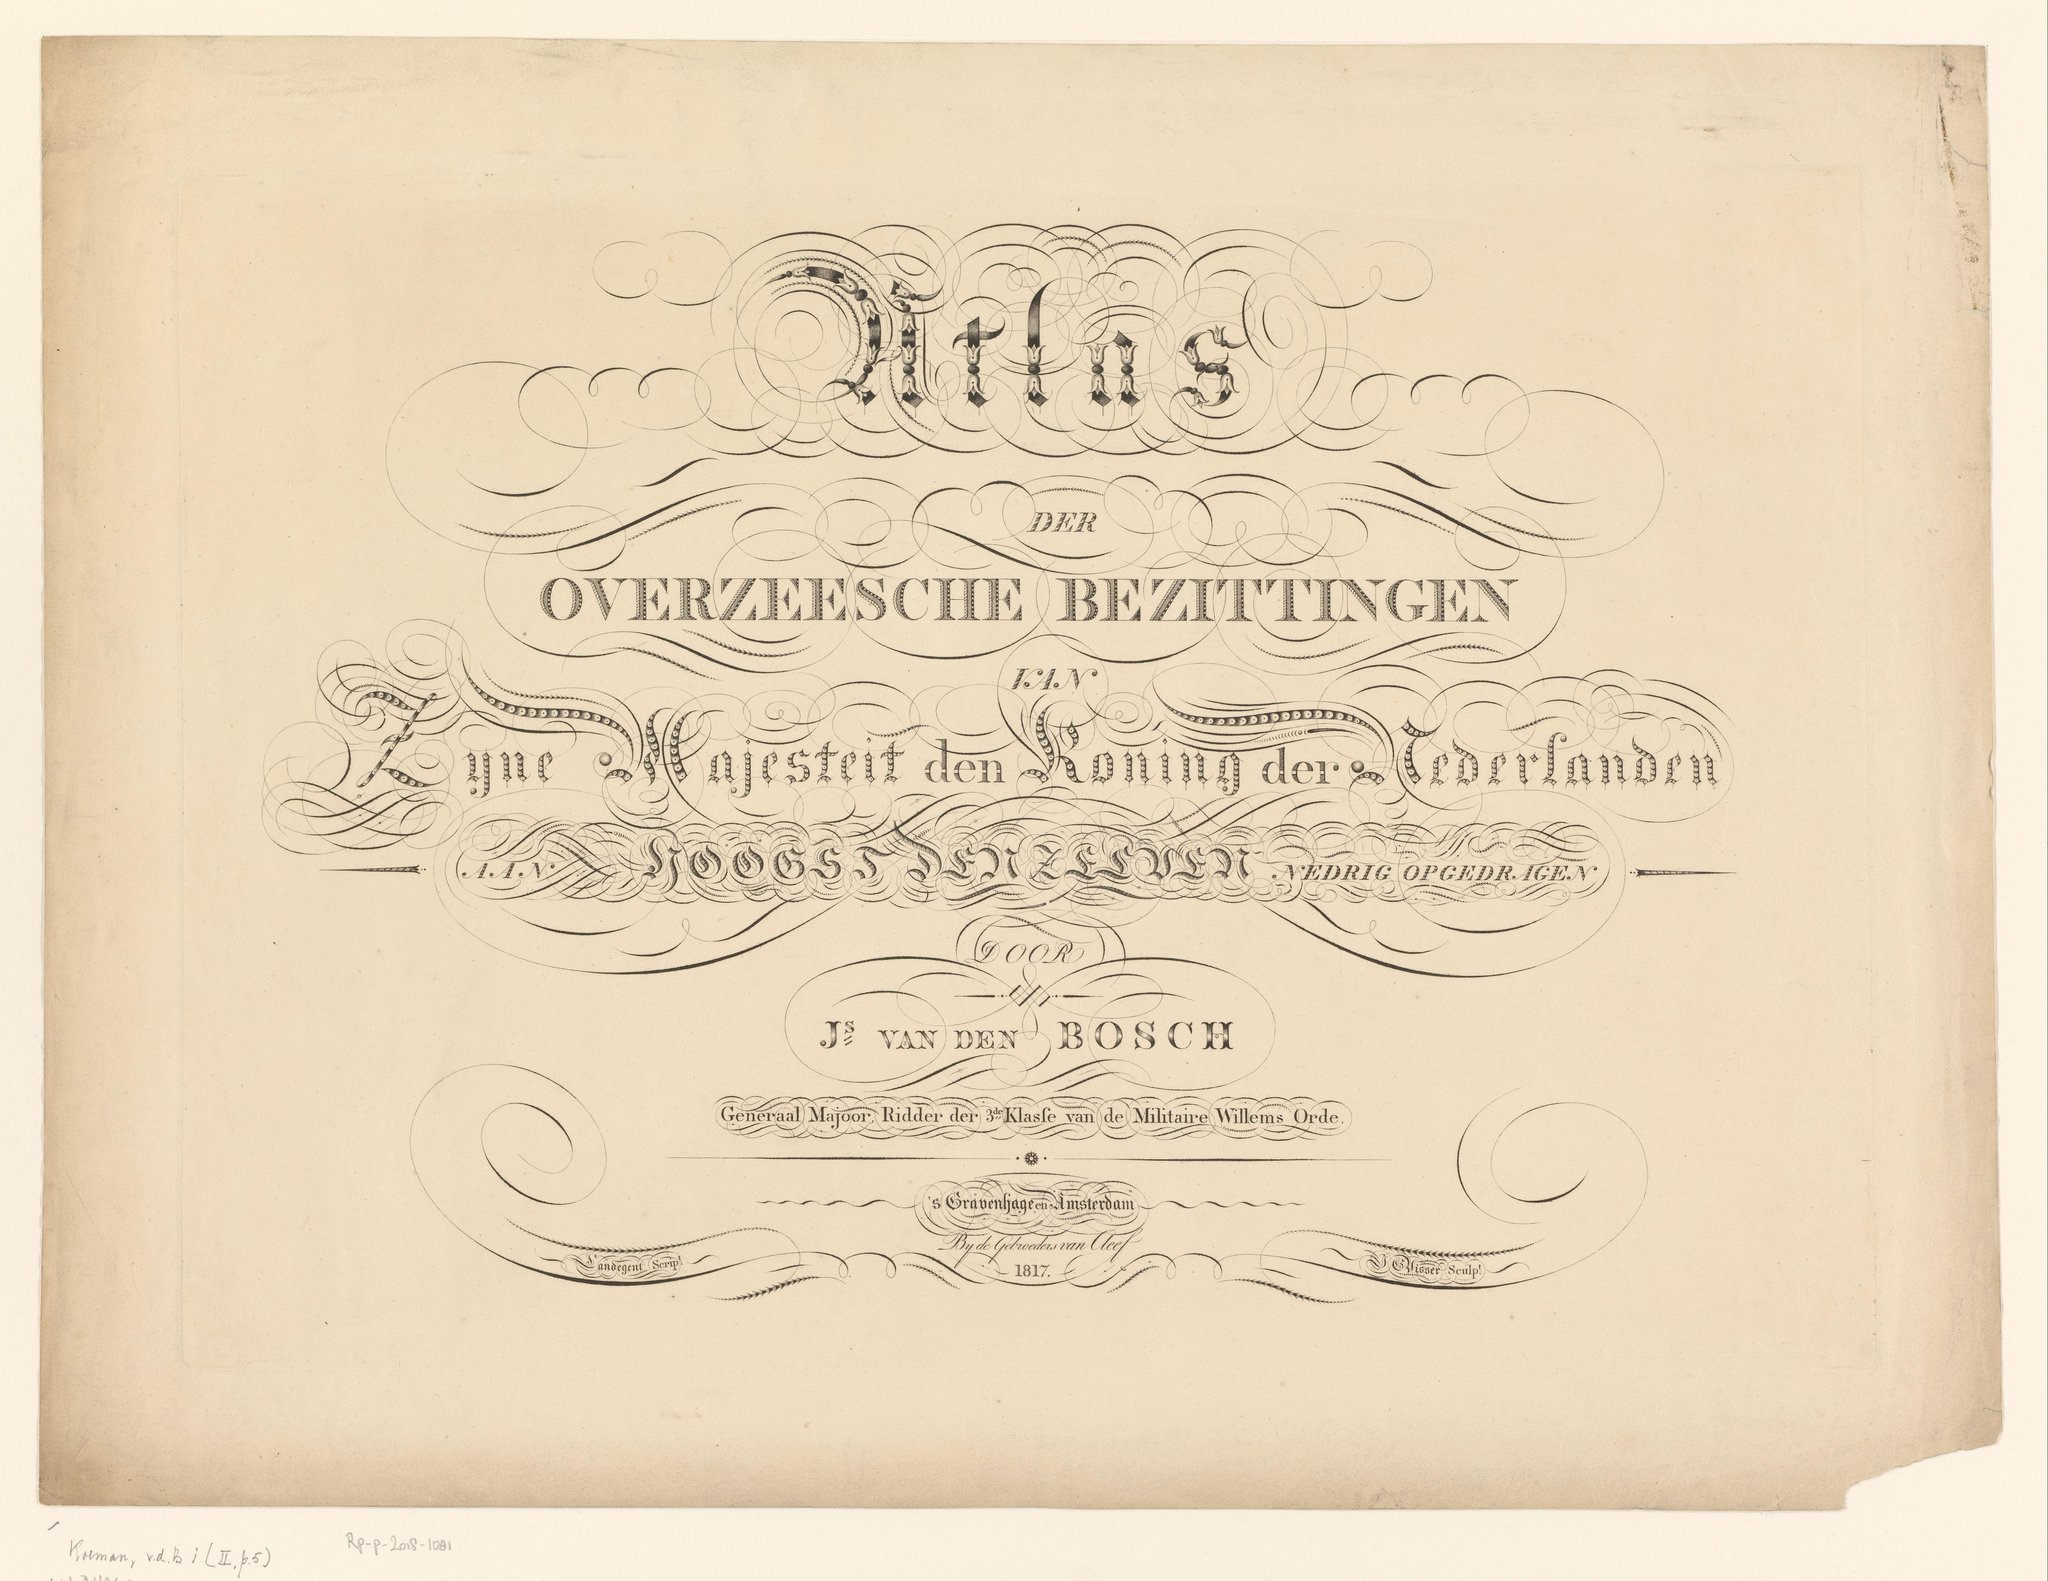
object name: titelblad, titelpagina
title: Titelpagina voor: J. van den Bosch, Atlas der overzeesche bezittingen, 1817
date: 1817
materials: paper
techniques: engraving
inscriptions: collector's mark: Lugt 2228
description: Titelpagina voor: Bosch, Johannes van den. Atlas der overzeesche bezittingen van Zijne Majesteit den Koning der Nederlanden. Den Haag en Amsterdam: Gebroeders van Cleef, 1817.